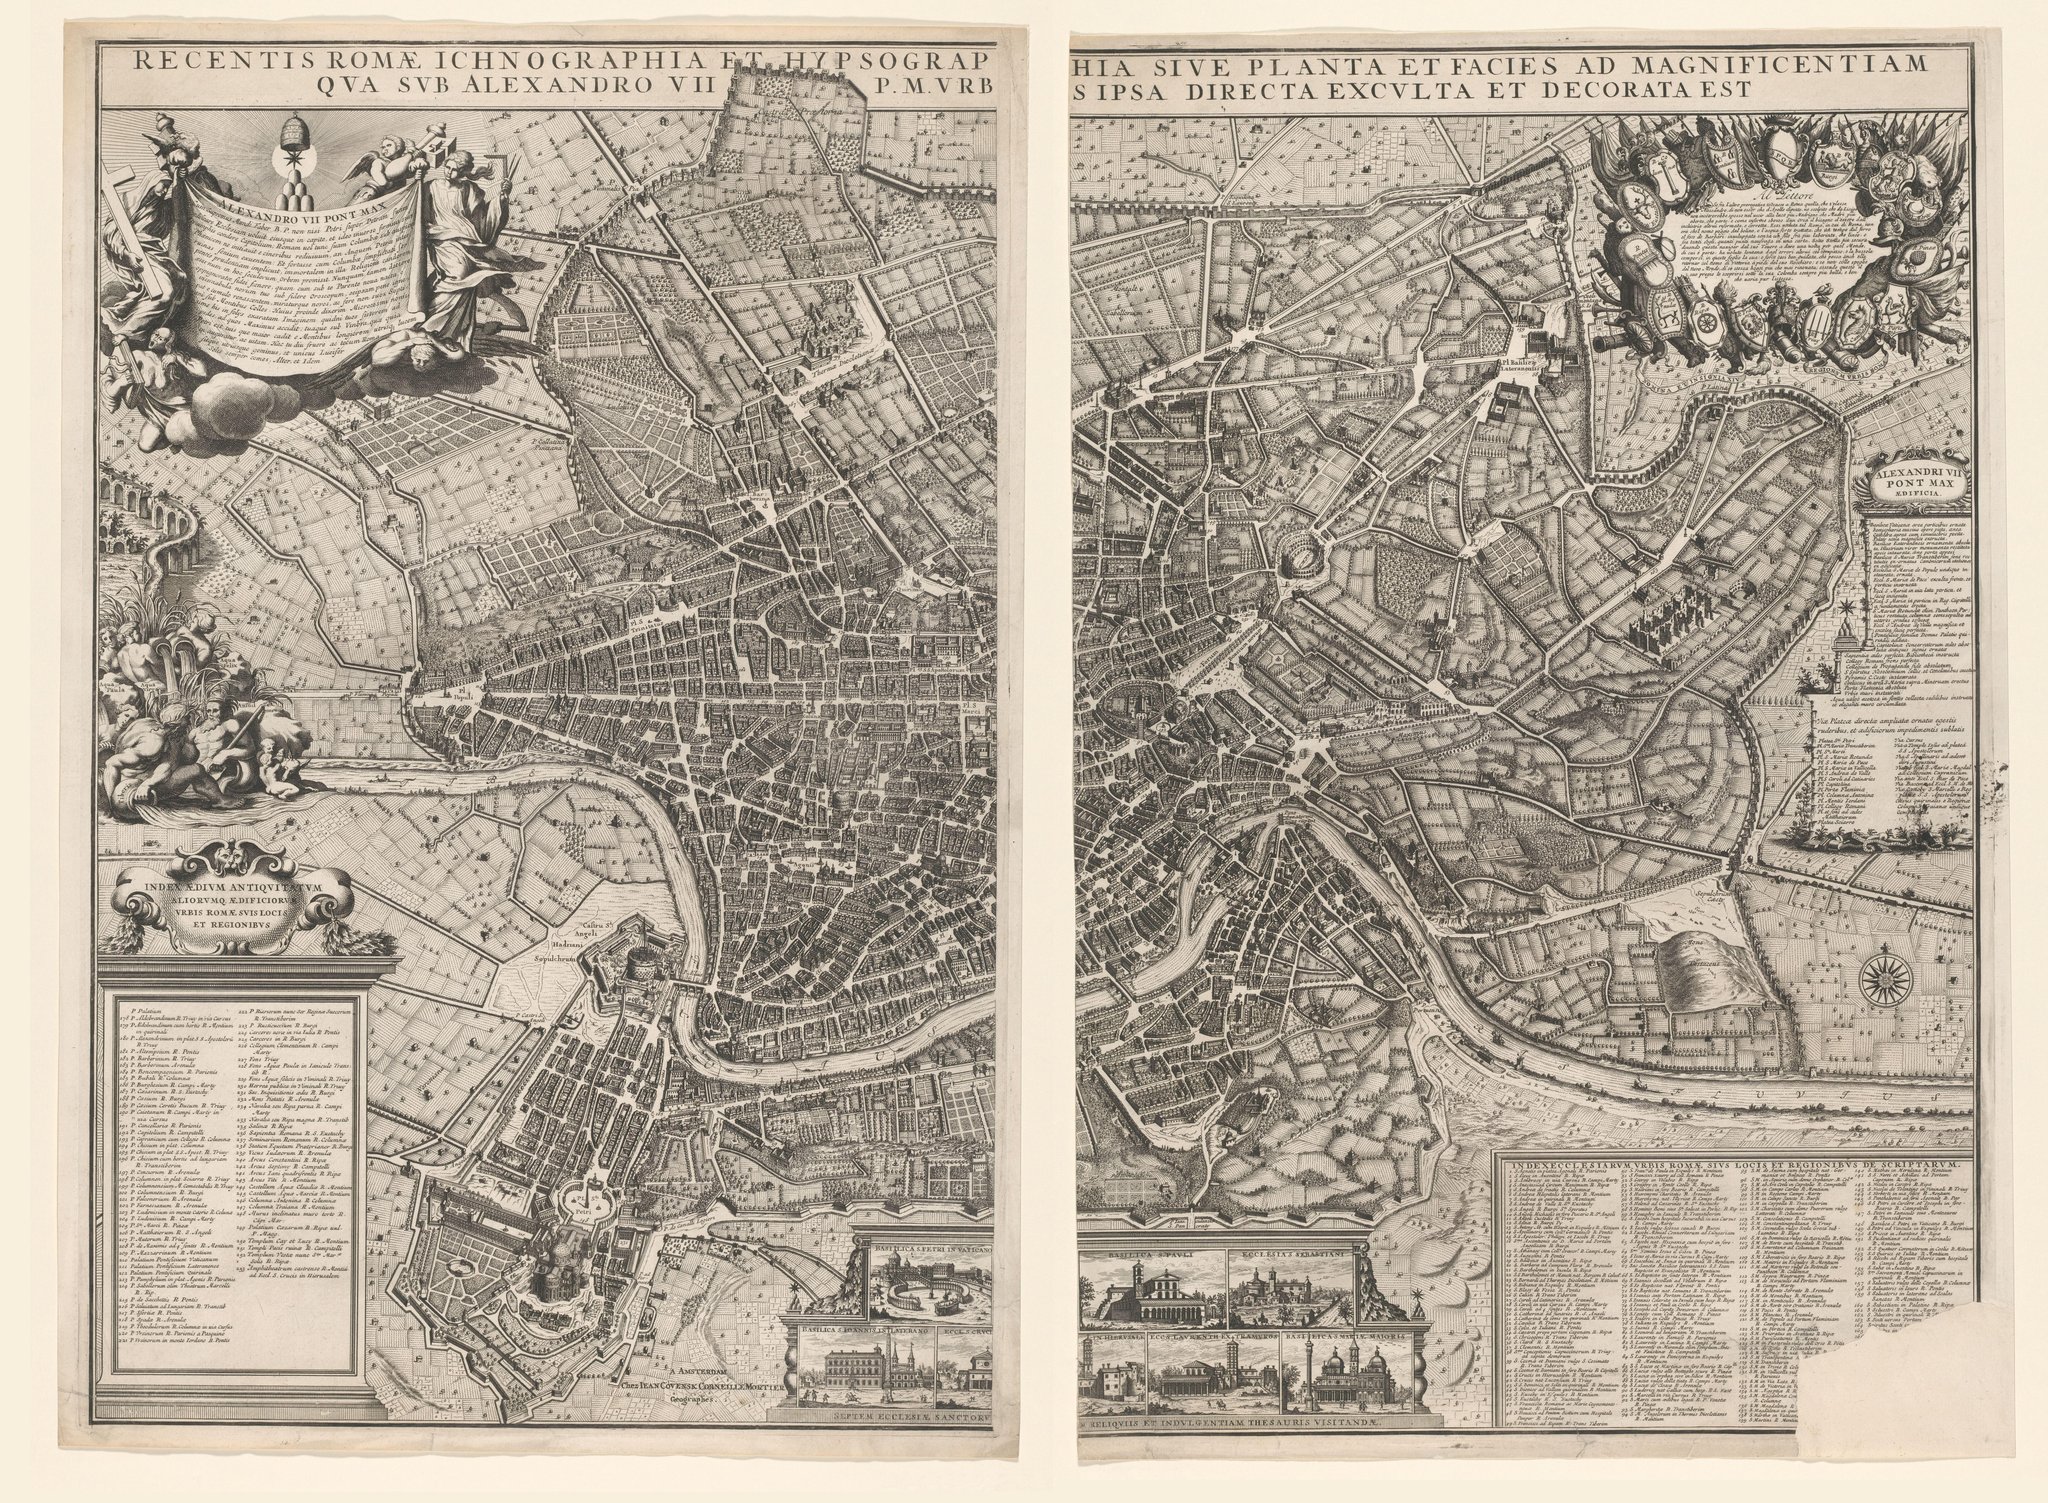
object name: area plan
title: Plattegrond van Rome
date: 1721-1774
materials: paper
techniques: engraving, etching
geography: amsterdam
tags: church (exterior), maps of cities, rome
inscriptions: collector's mark: Lugt 2228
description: Plattegrond van Rome, bestaande uit twee delen. Onder een inzet met zeven gezichten op belangrijke kerken in Rome.